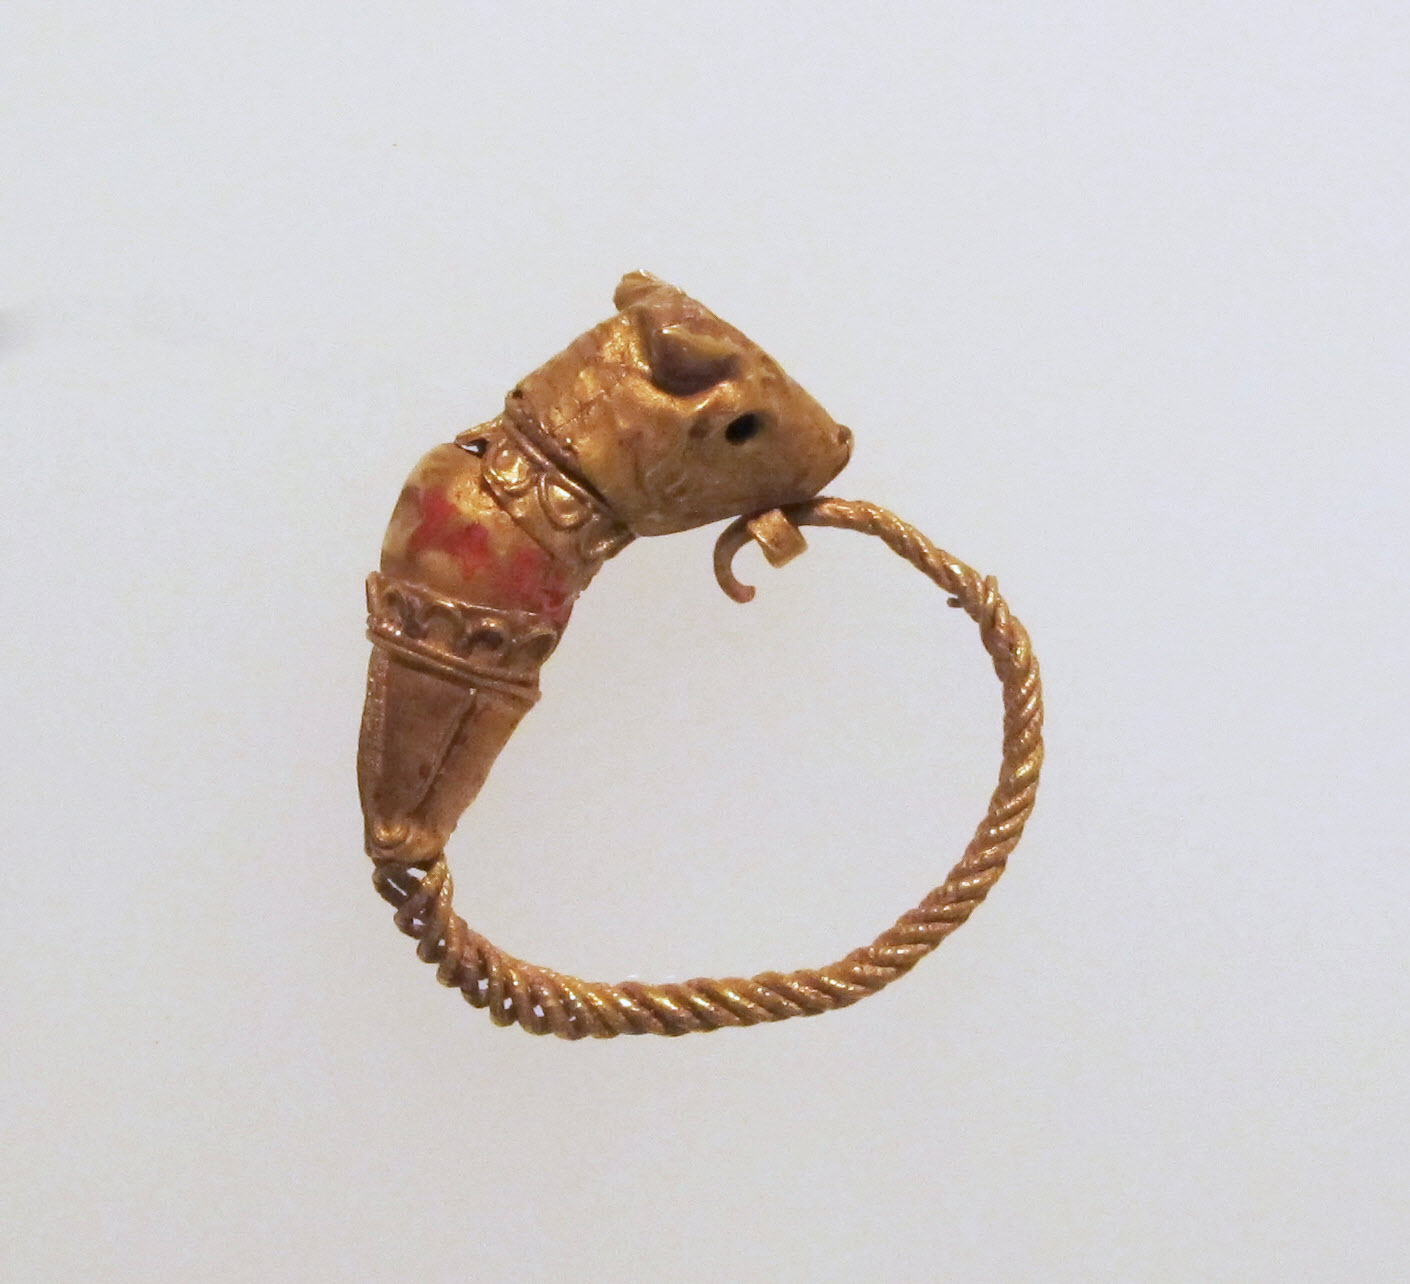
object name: earring with head of bull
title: Gold earring with head of a bull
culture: greek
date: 400-201 BCE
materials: gold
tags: bulls